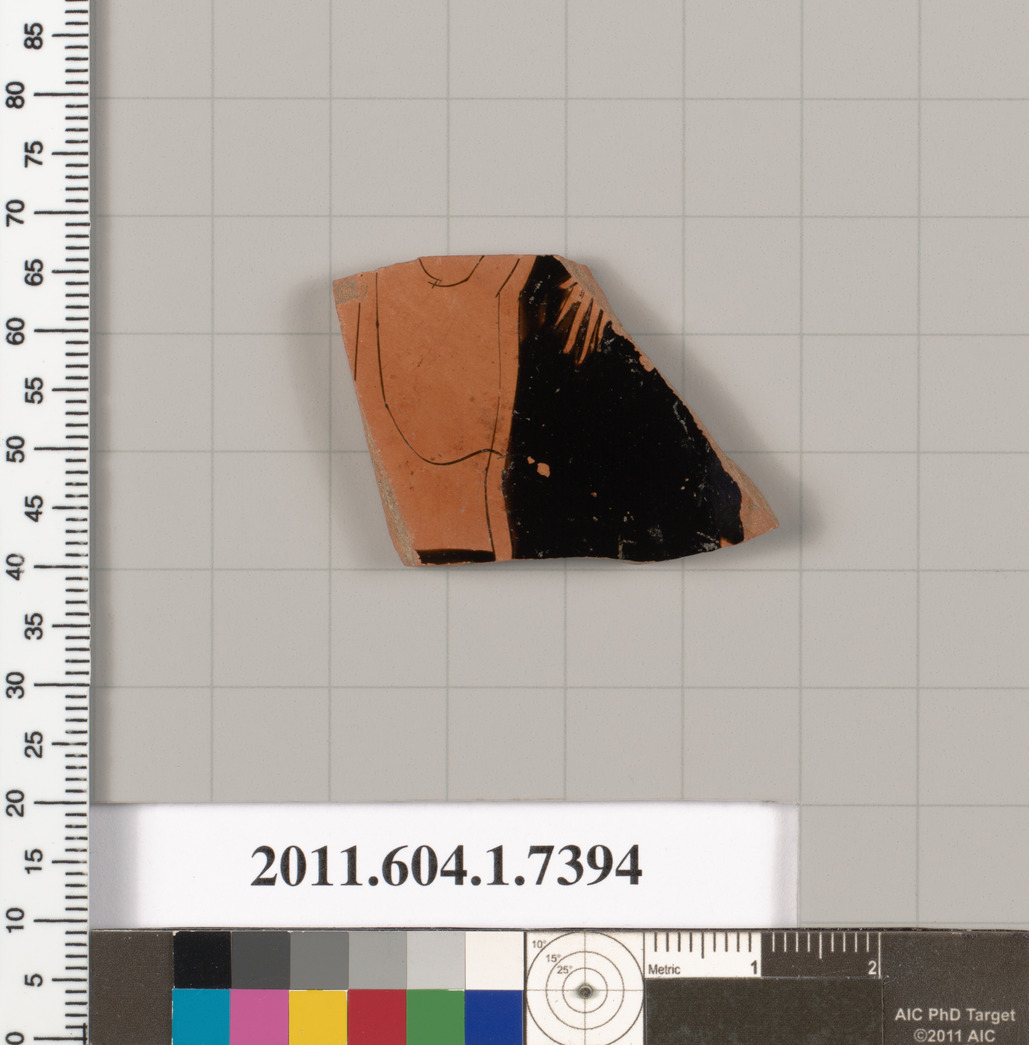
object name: kylix fragment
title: Terracotta fragment of a kylix (drinking cup)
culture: greek, attic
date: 500-480 BCE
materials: terracotta